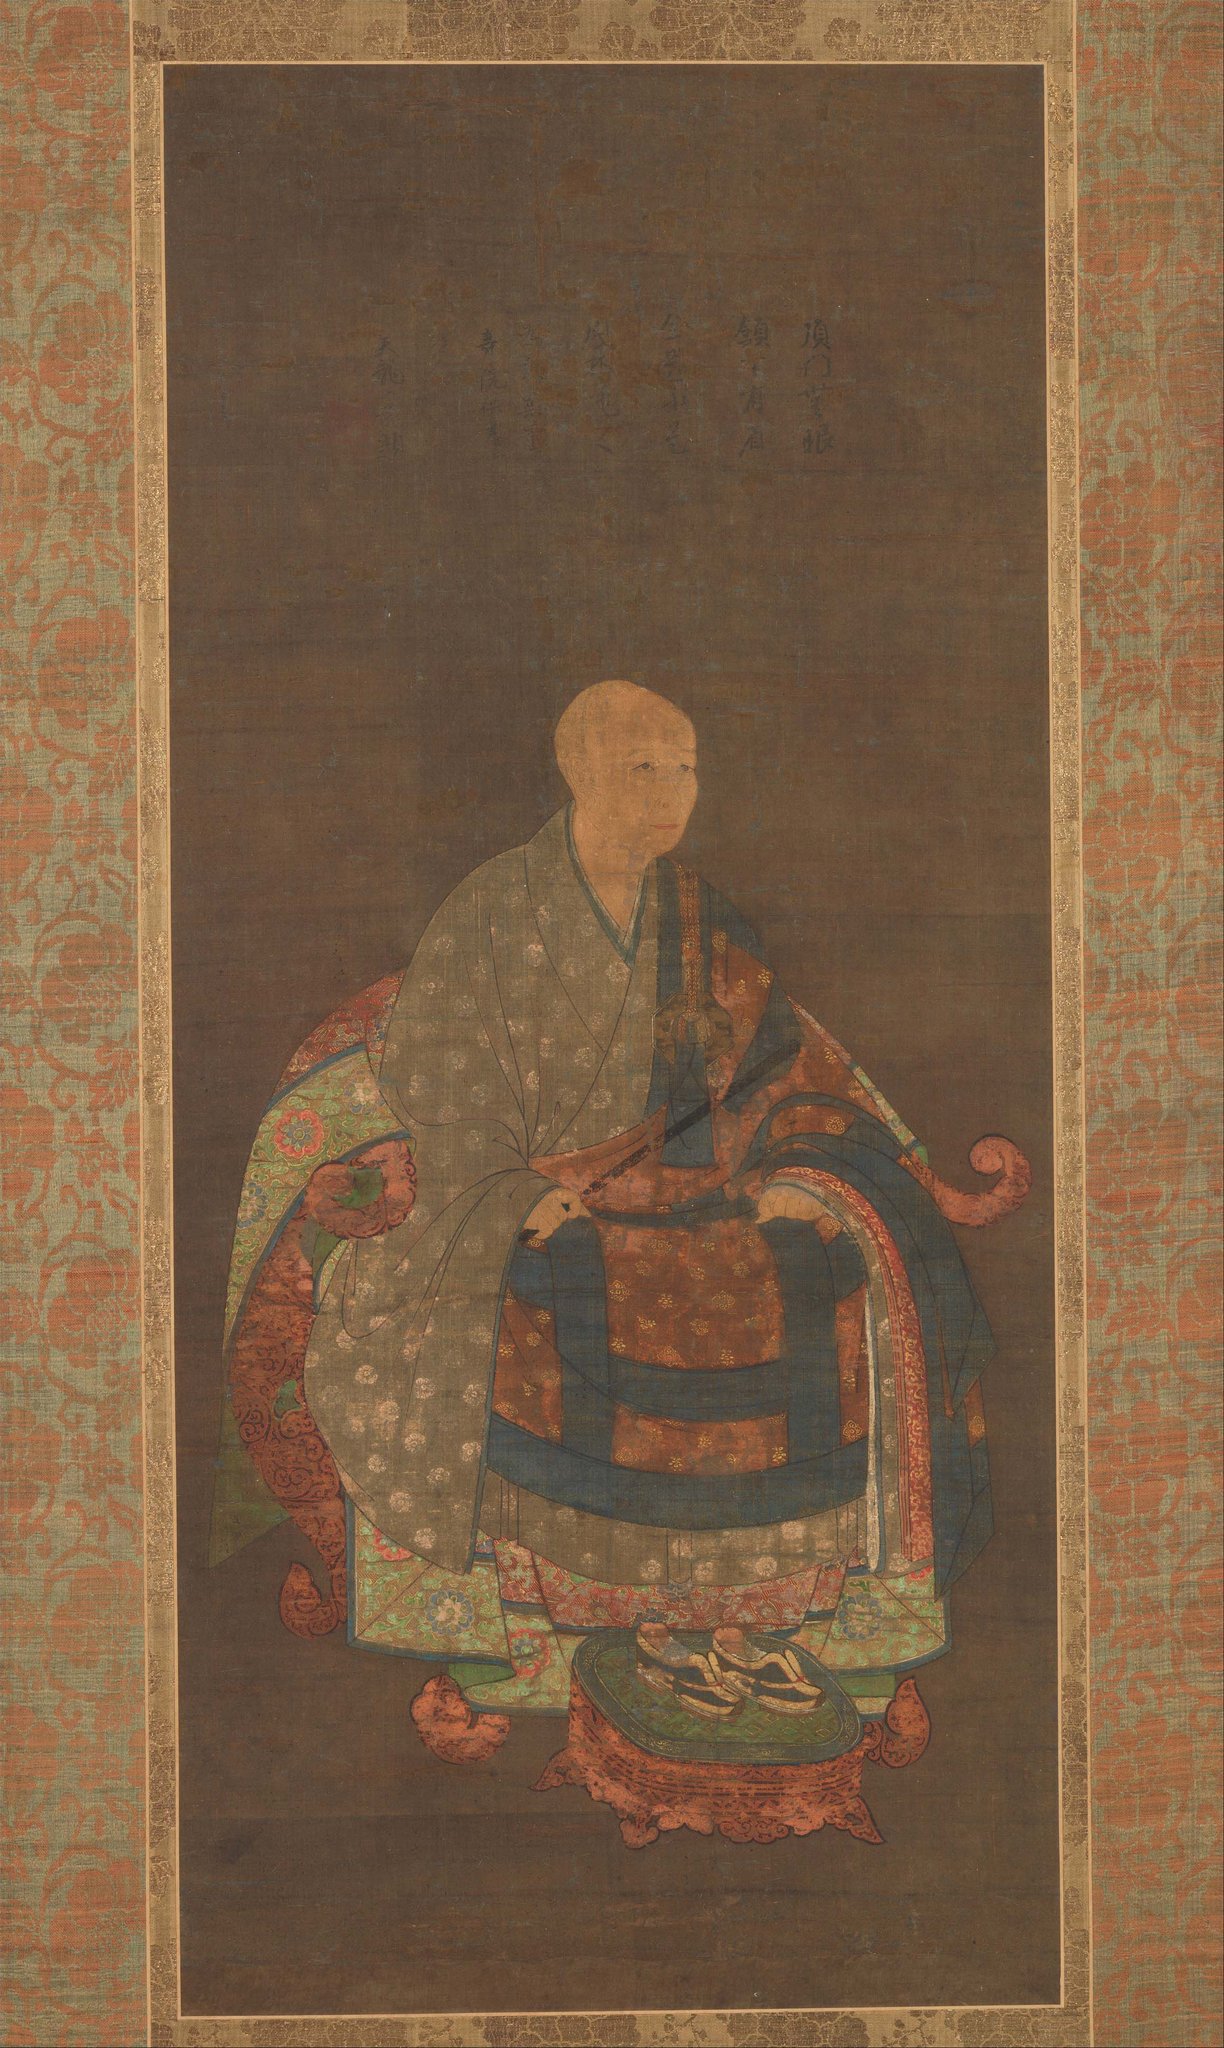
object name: hanging scroll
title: Portrait of Shun'oku Myōha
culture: japanese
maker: unidentified artist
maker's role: artist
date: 1383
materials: gold, ink, silk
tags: poetry,men,portraits